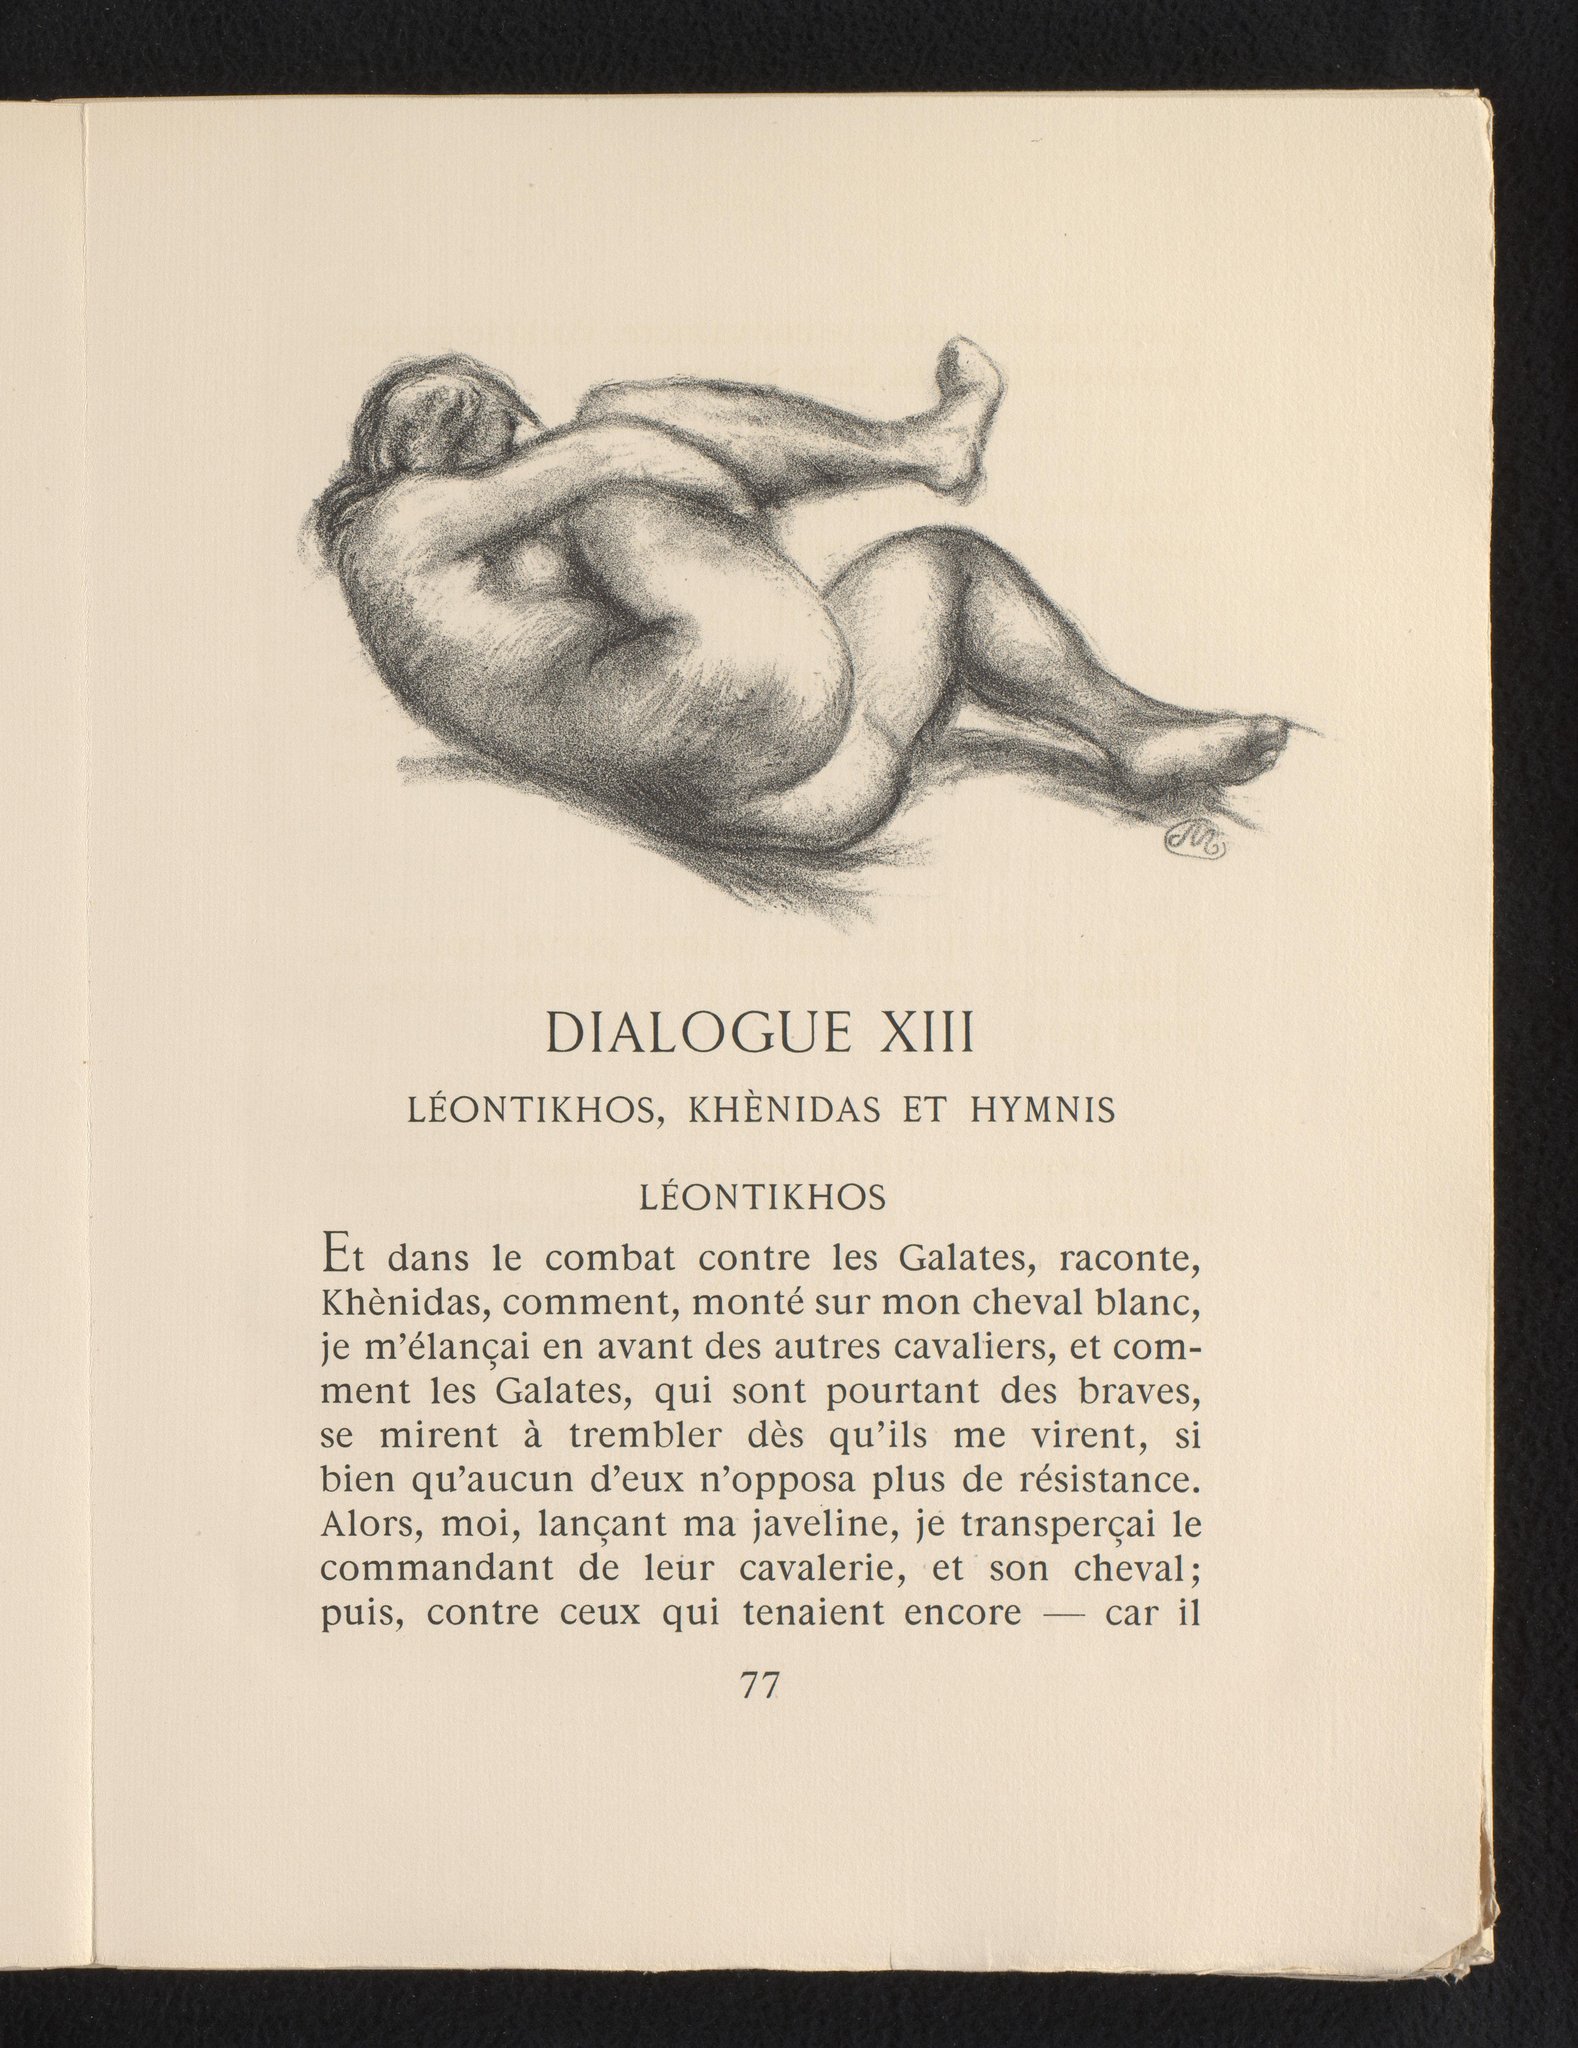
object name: book illustration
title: Op haar rug liggende naakte vrouw, een arm om haar rechterknieholte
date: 1948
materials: paper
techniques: letterpress printing, lithograph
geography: paris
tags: woman (showing herself) undressed, quasi-nude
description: Prent uit: Lucianus van Samosata. Dialogues des Courtisanes. [Vertaald uit het Grieks door] Charles Astruc. Parijs: s.n., 1948, p. 77.